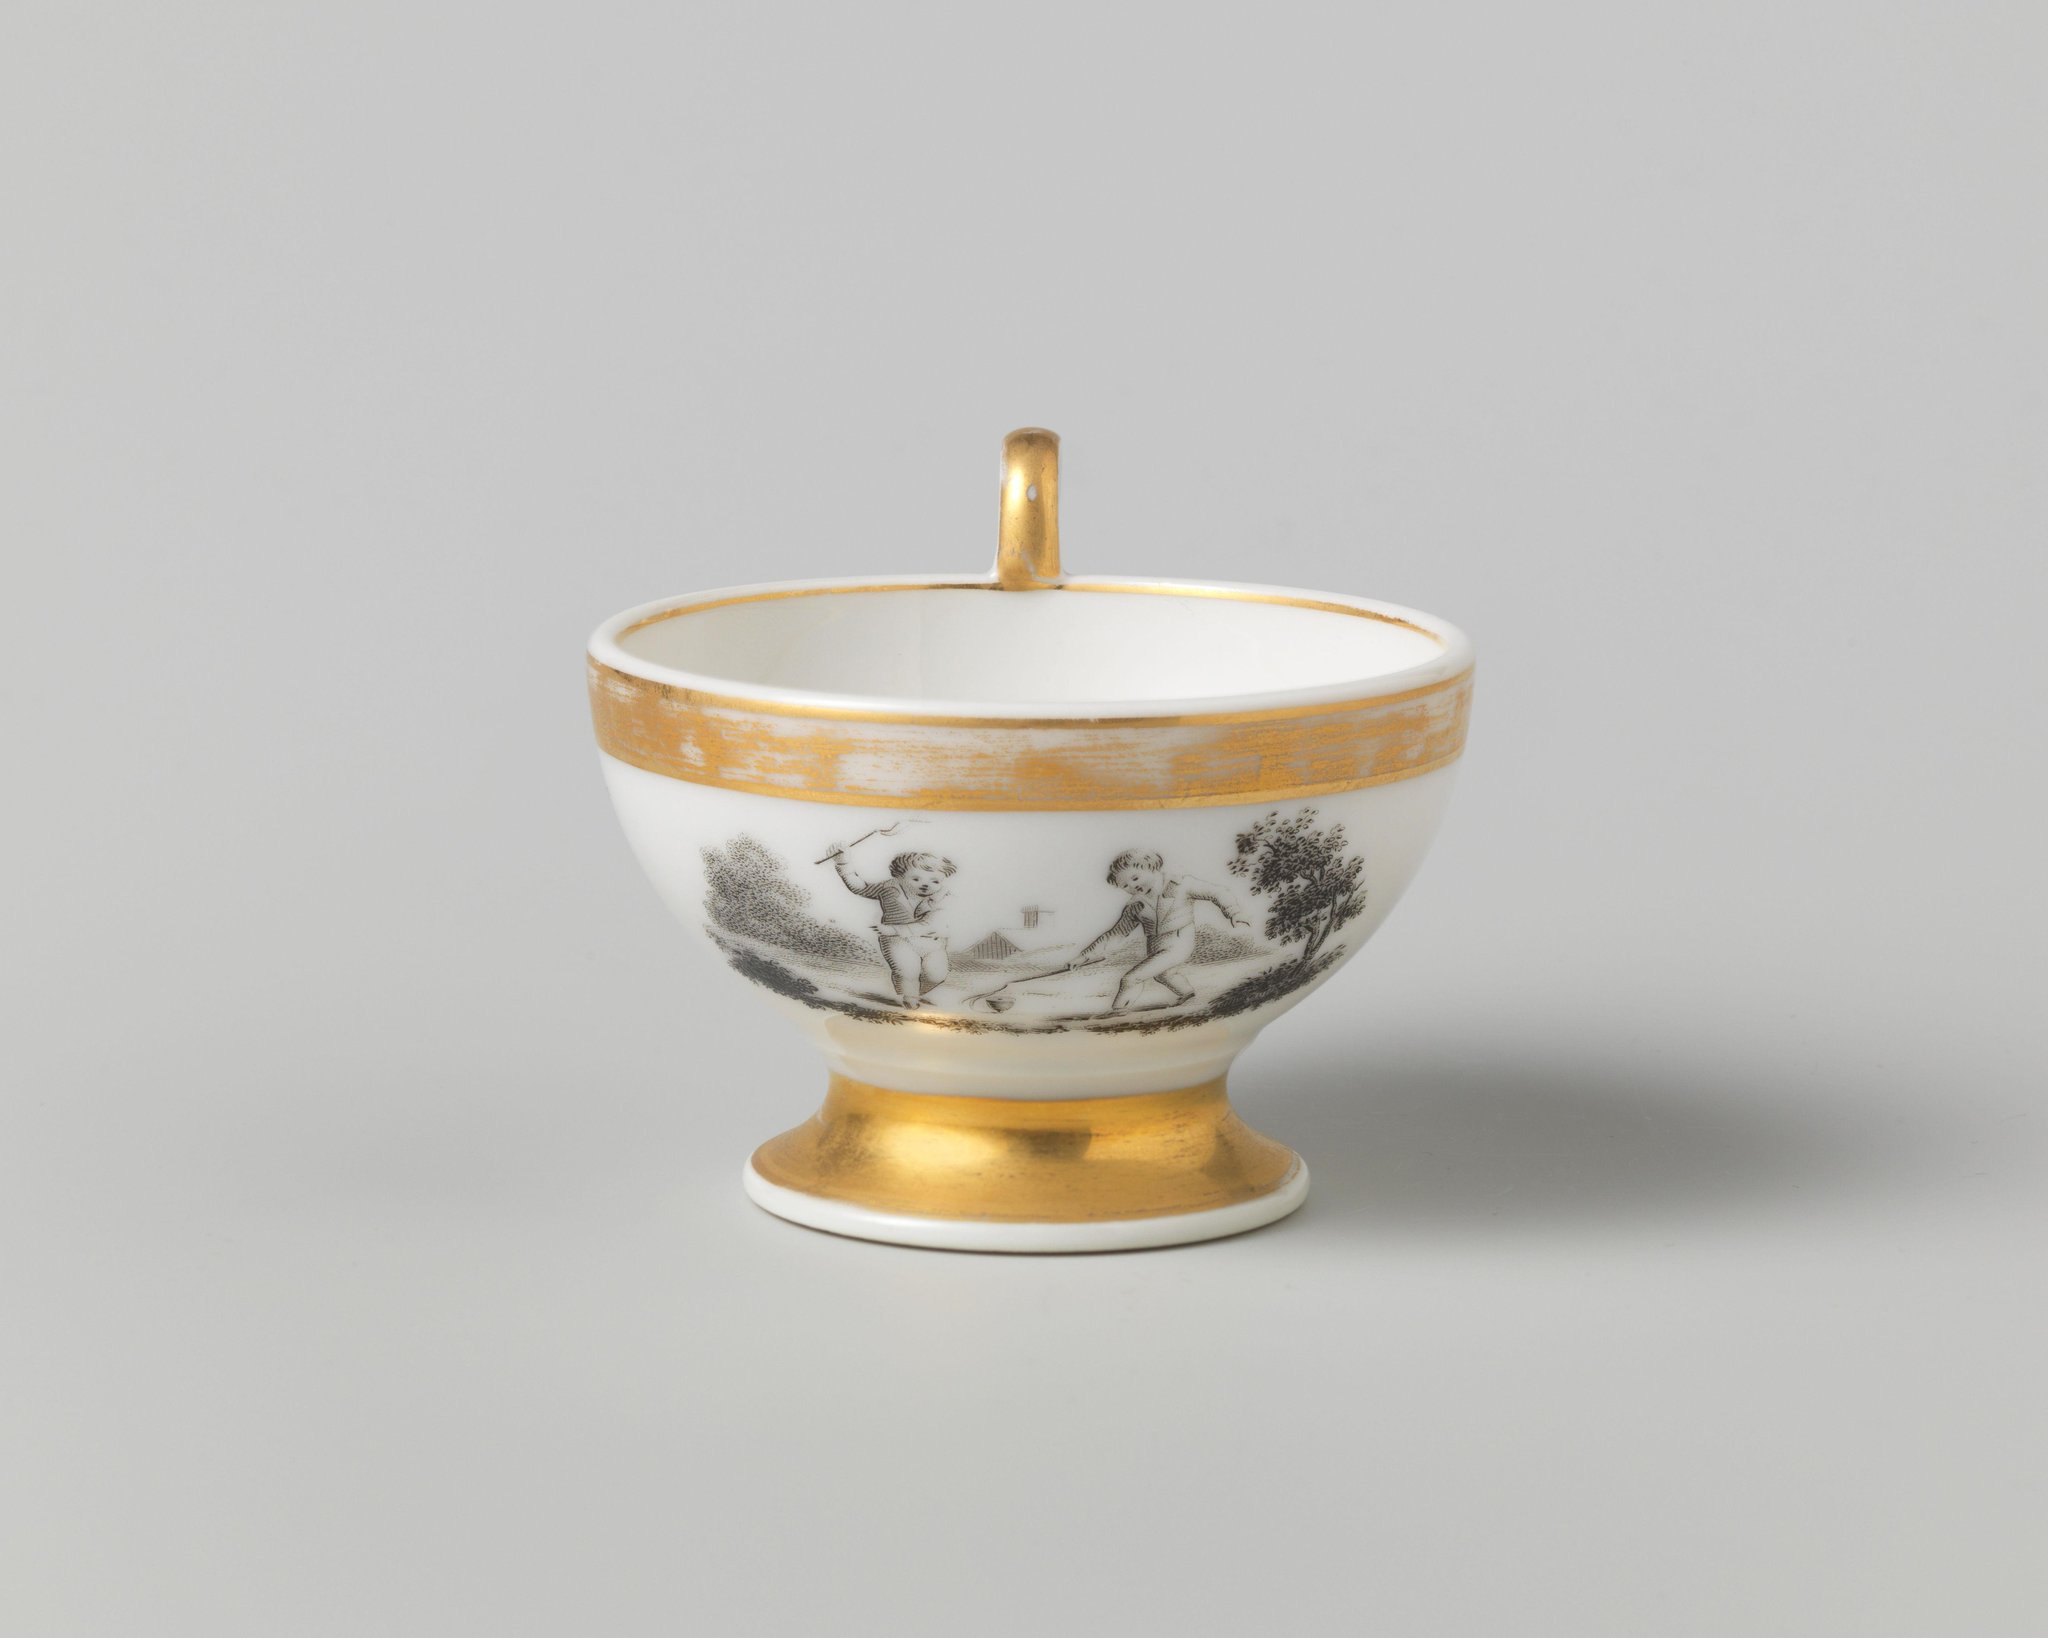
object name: cup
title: Cup with different figures in a landscape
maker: Anonymous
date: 1850-1899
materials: glaze, gold, paint, porcelain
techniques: firing, forming, gilding, turning, vitrification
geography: europe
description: Kop van porselein, op hoge voet en met vraagtekenvormig oor. Behoort tot een serie van twaalf kop en schotels. Langs de mondrand een brede gouden bies, het oor is verguld. De kop is versierd met een drukdecor in zwart, voorstellende spelende kinderen of volwassenen in een landschap.